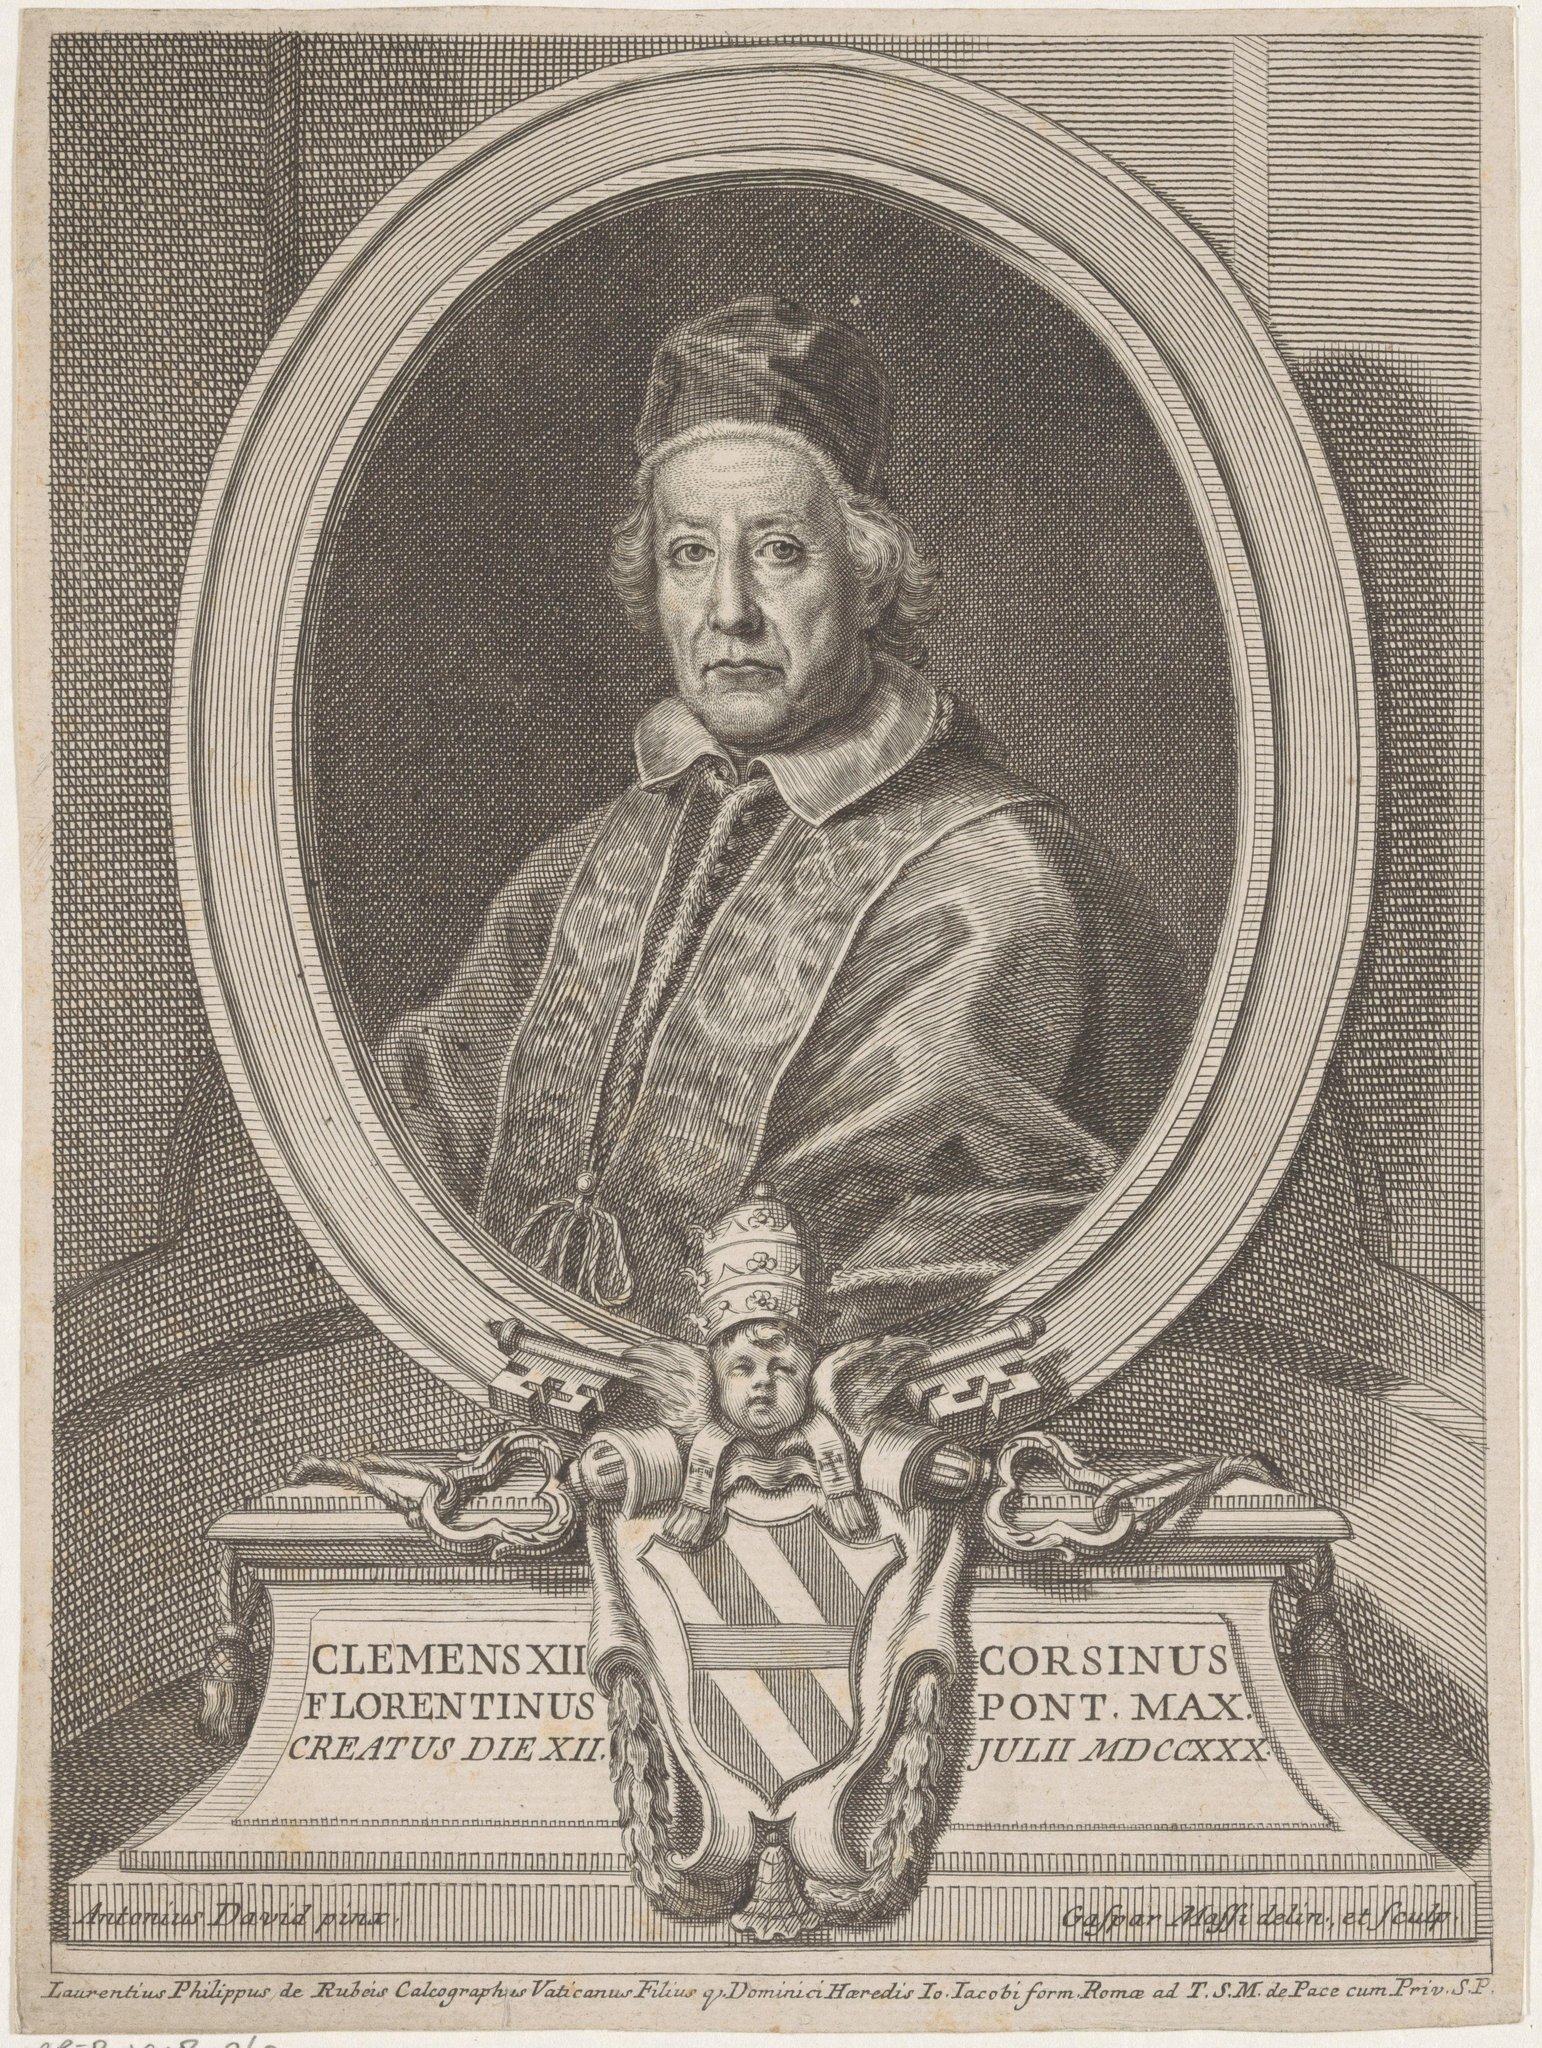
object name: print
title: Portret van Paus Clemens XII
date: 1730-1731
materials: paper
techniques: engraving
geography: rome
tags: clemens xii, historical persons, pope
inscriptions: collector's mark: Lugt 2228